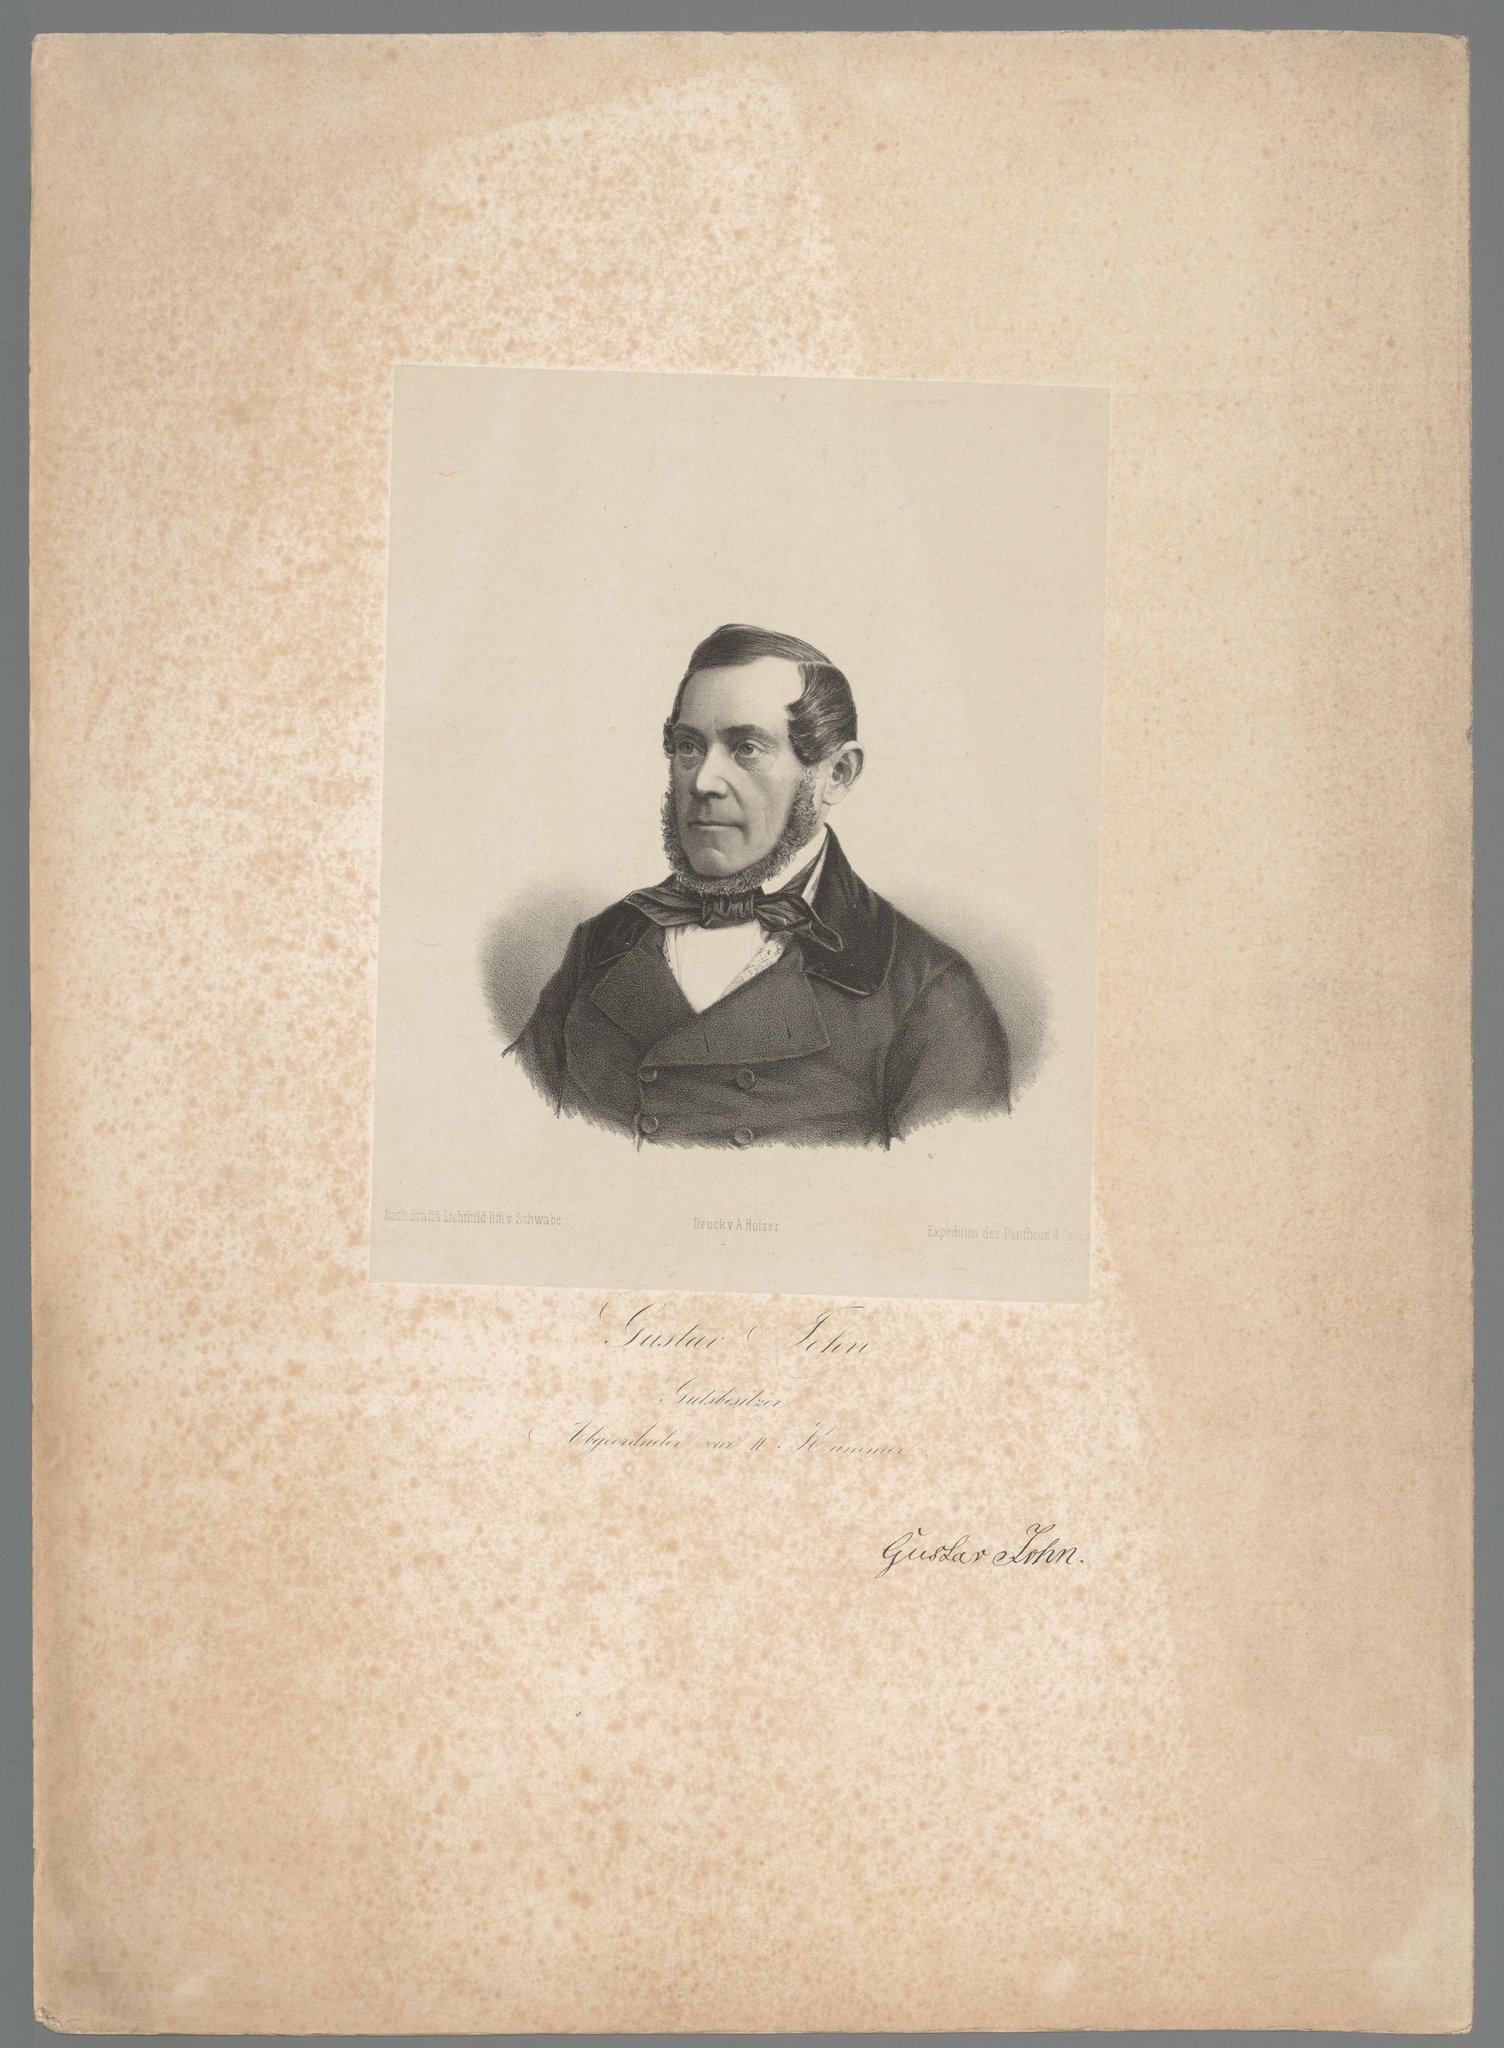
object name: print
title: Expedition des Pantheon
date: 1830-1860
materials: paper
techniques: lithograph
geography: berlin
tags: adult man, historical persons, beard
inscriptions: collector's mark: Lugt 2228